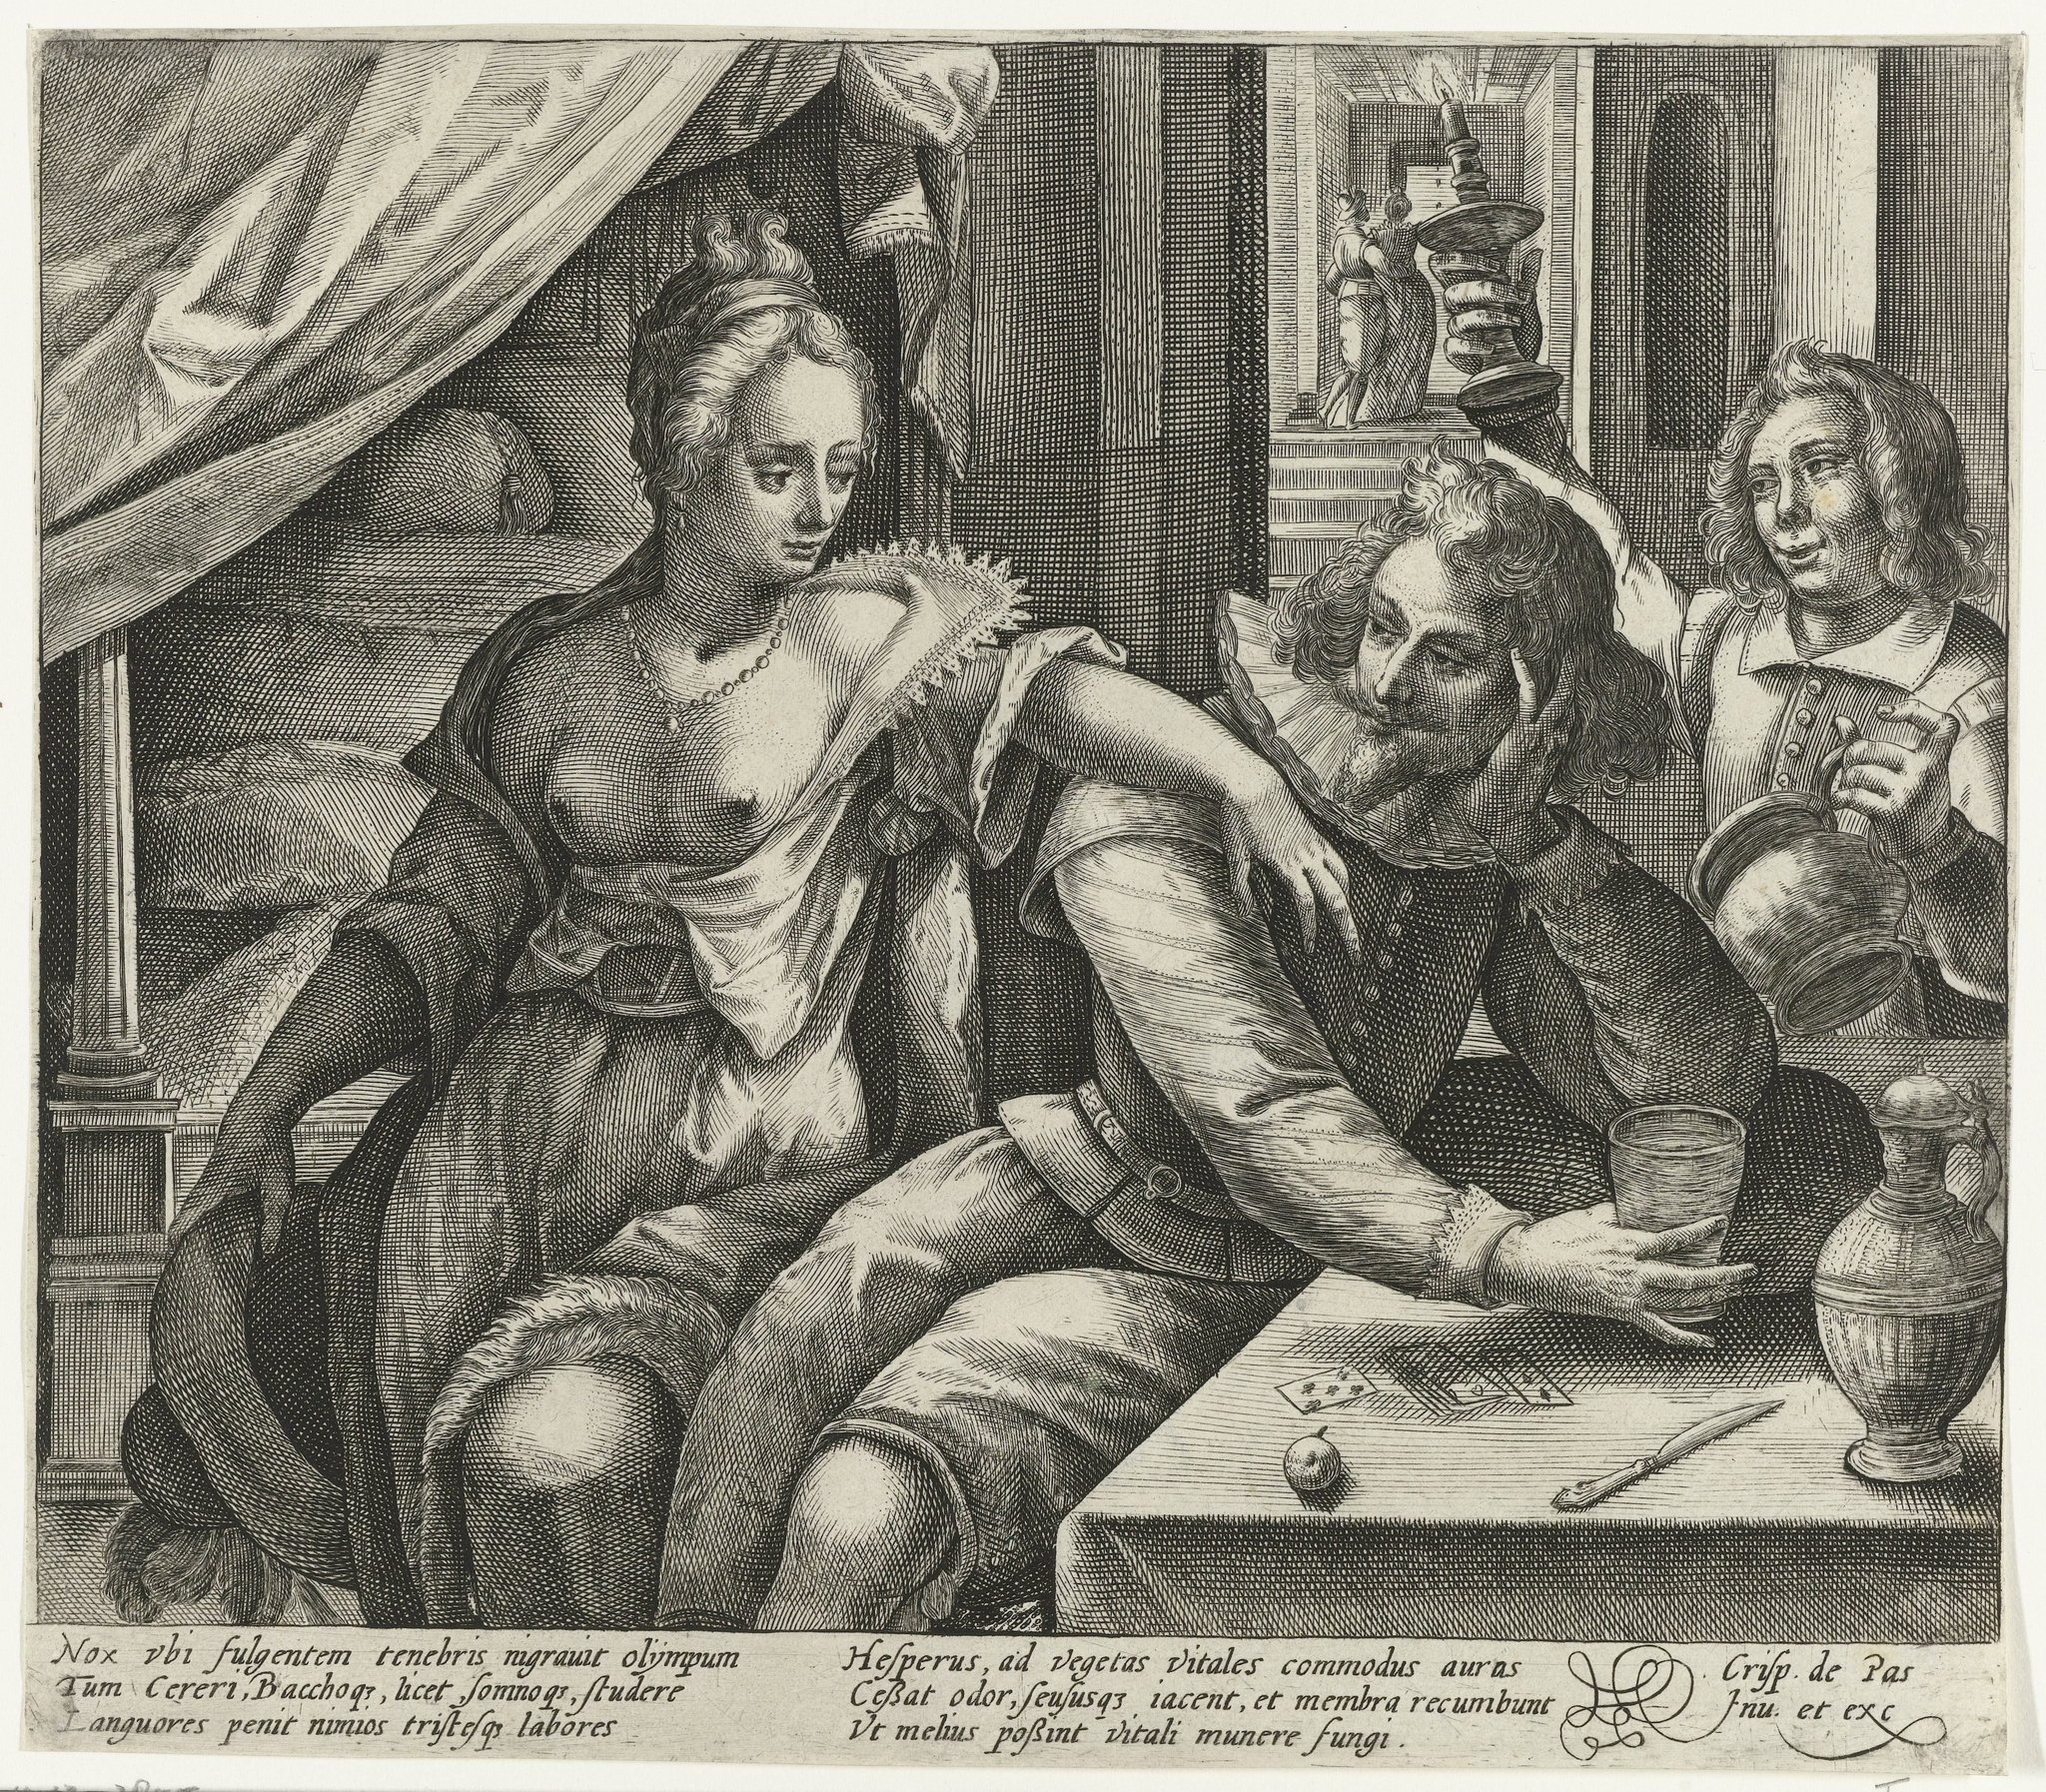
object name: print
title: Nacht: paar in slaapkamer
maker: crispijn van de passe (i)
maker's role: draughtsman, print maker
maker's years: 1564-1637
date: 1574-1637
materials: paper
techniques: engraving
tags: candlestick (+ giving someone a light), personification of the night, 'nox'; 'notte', 'carro della notte', 'serenità della notte' (ripa), bedroom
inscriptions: collector's mark: Lugt 2228, collector's mark: Lugt 2542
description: De Nacht: slaapkamer met een man die aan een tafel zit en een vrouw, in jurk met ontbloot decolleté, die naar bed gaat. Een jongeman belicht hen met een brandende kaars. In de marge een zesregelig onderschrift, in twee kolommen, in het Latijn dat verwijst naar de nacht.